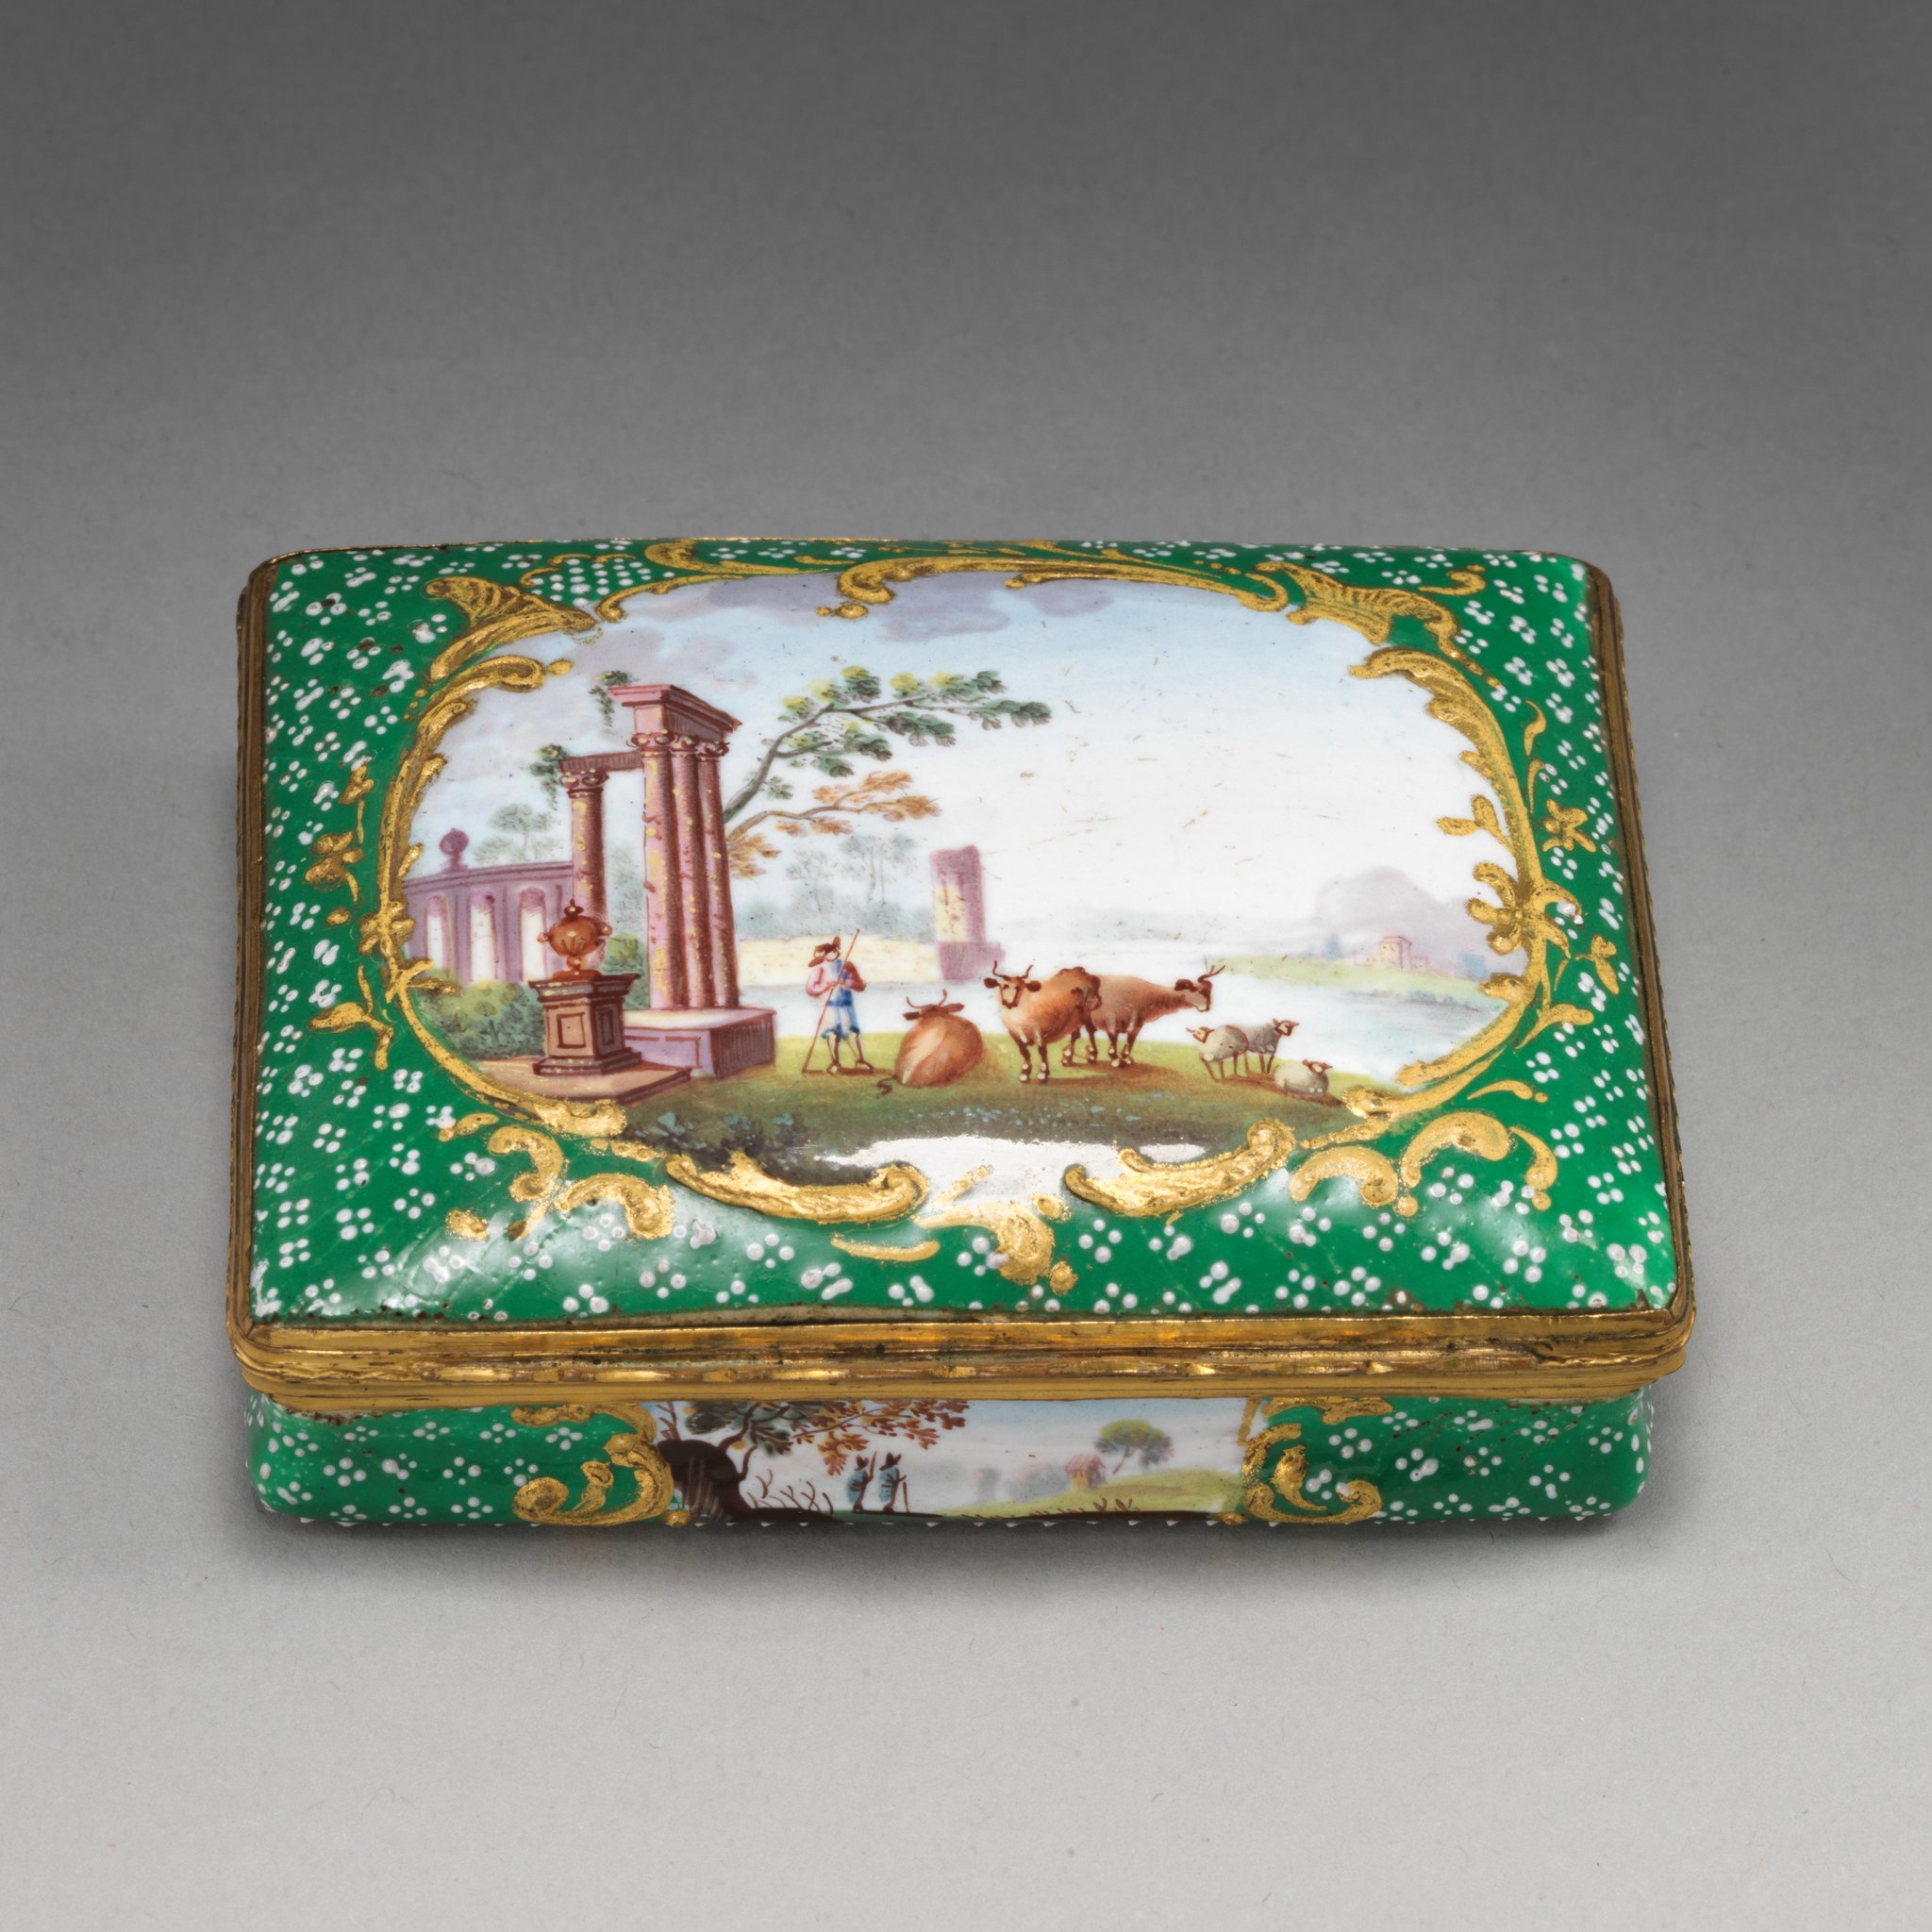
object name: snuffbox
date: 1770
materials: copper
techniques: enamel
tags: cows,landscapes